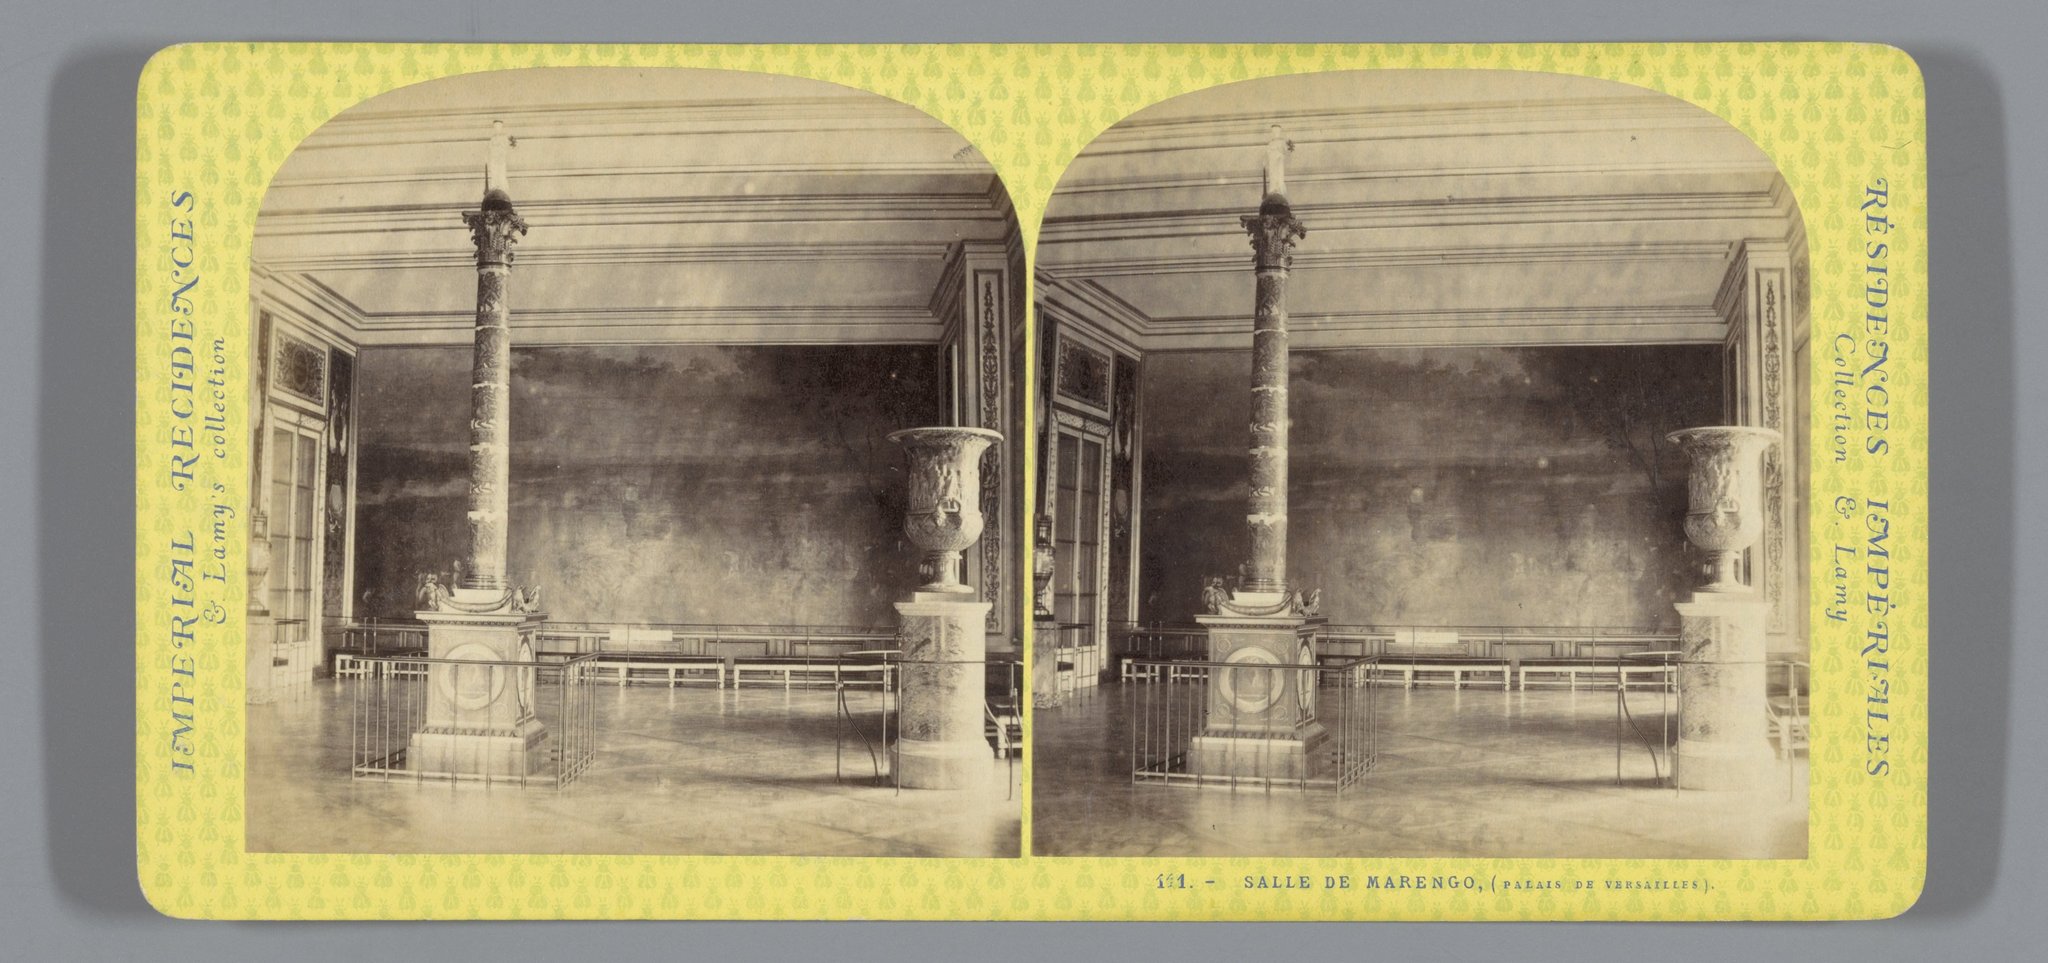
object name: stereograph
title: Imperial Residences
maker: ernest eléonor pierre lamy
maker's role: publisher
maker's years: 1828-1900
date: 1860-1880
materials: cardboard, photographic support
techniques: albumen print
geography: versailles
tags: palace, interior ~ representation of a building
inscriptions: number: ‘111.’, inscription: ‘E. Lamy's collection’